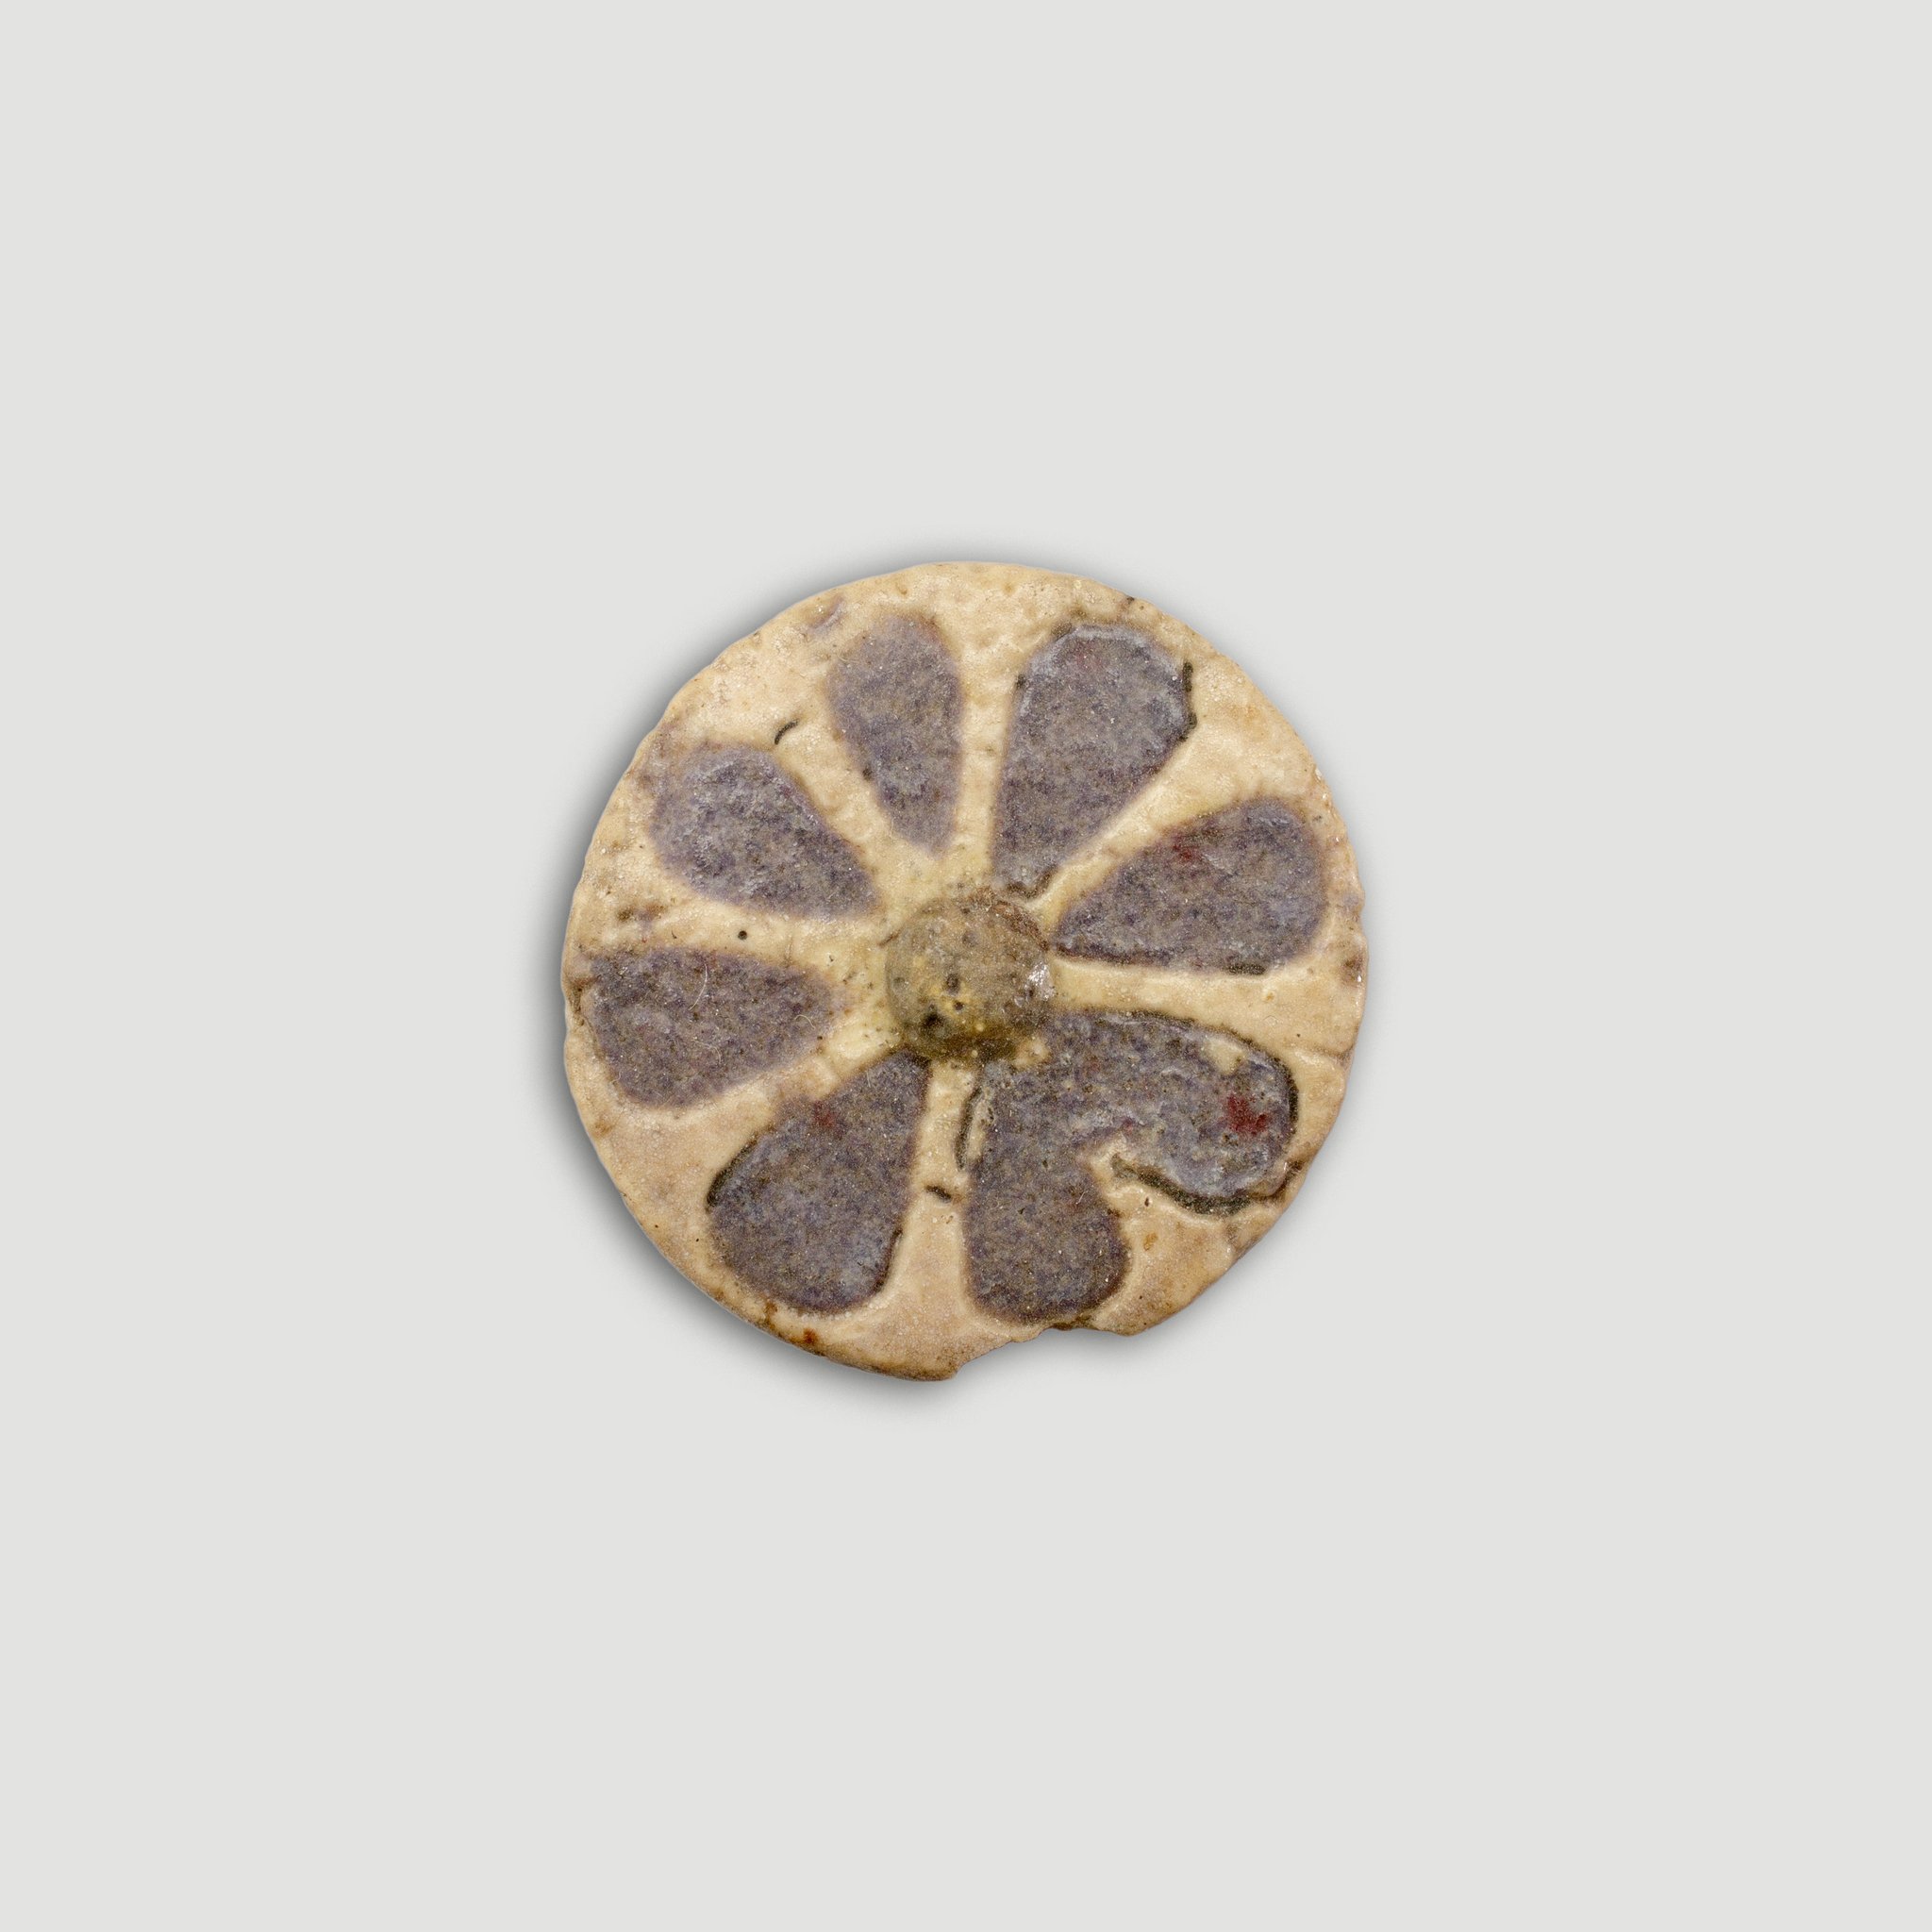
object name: tile, palace of ramesses ii, rosette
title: Tiles and ornaments from the palace of Ramesses II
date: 1279-1213 BCE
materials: faience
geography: egypt